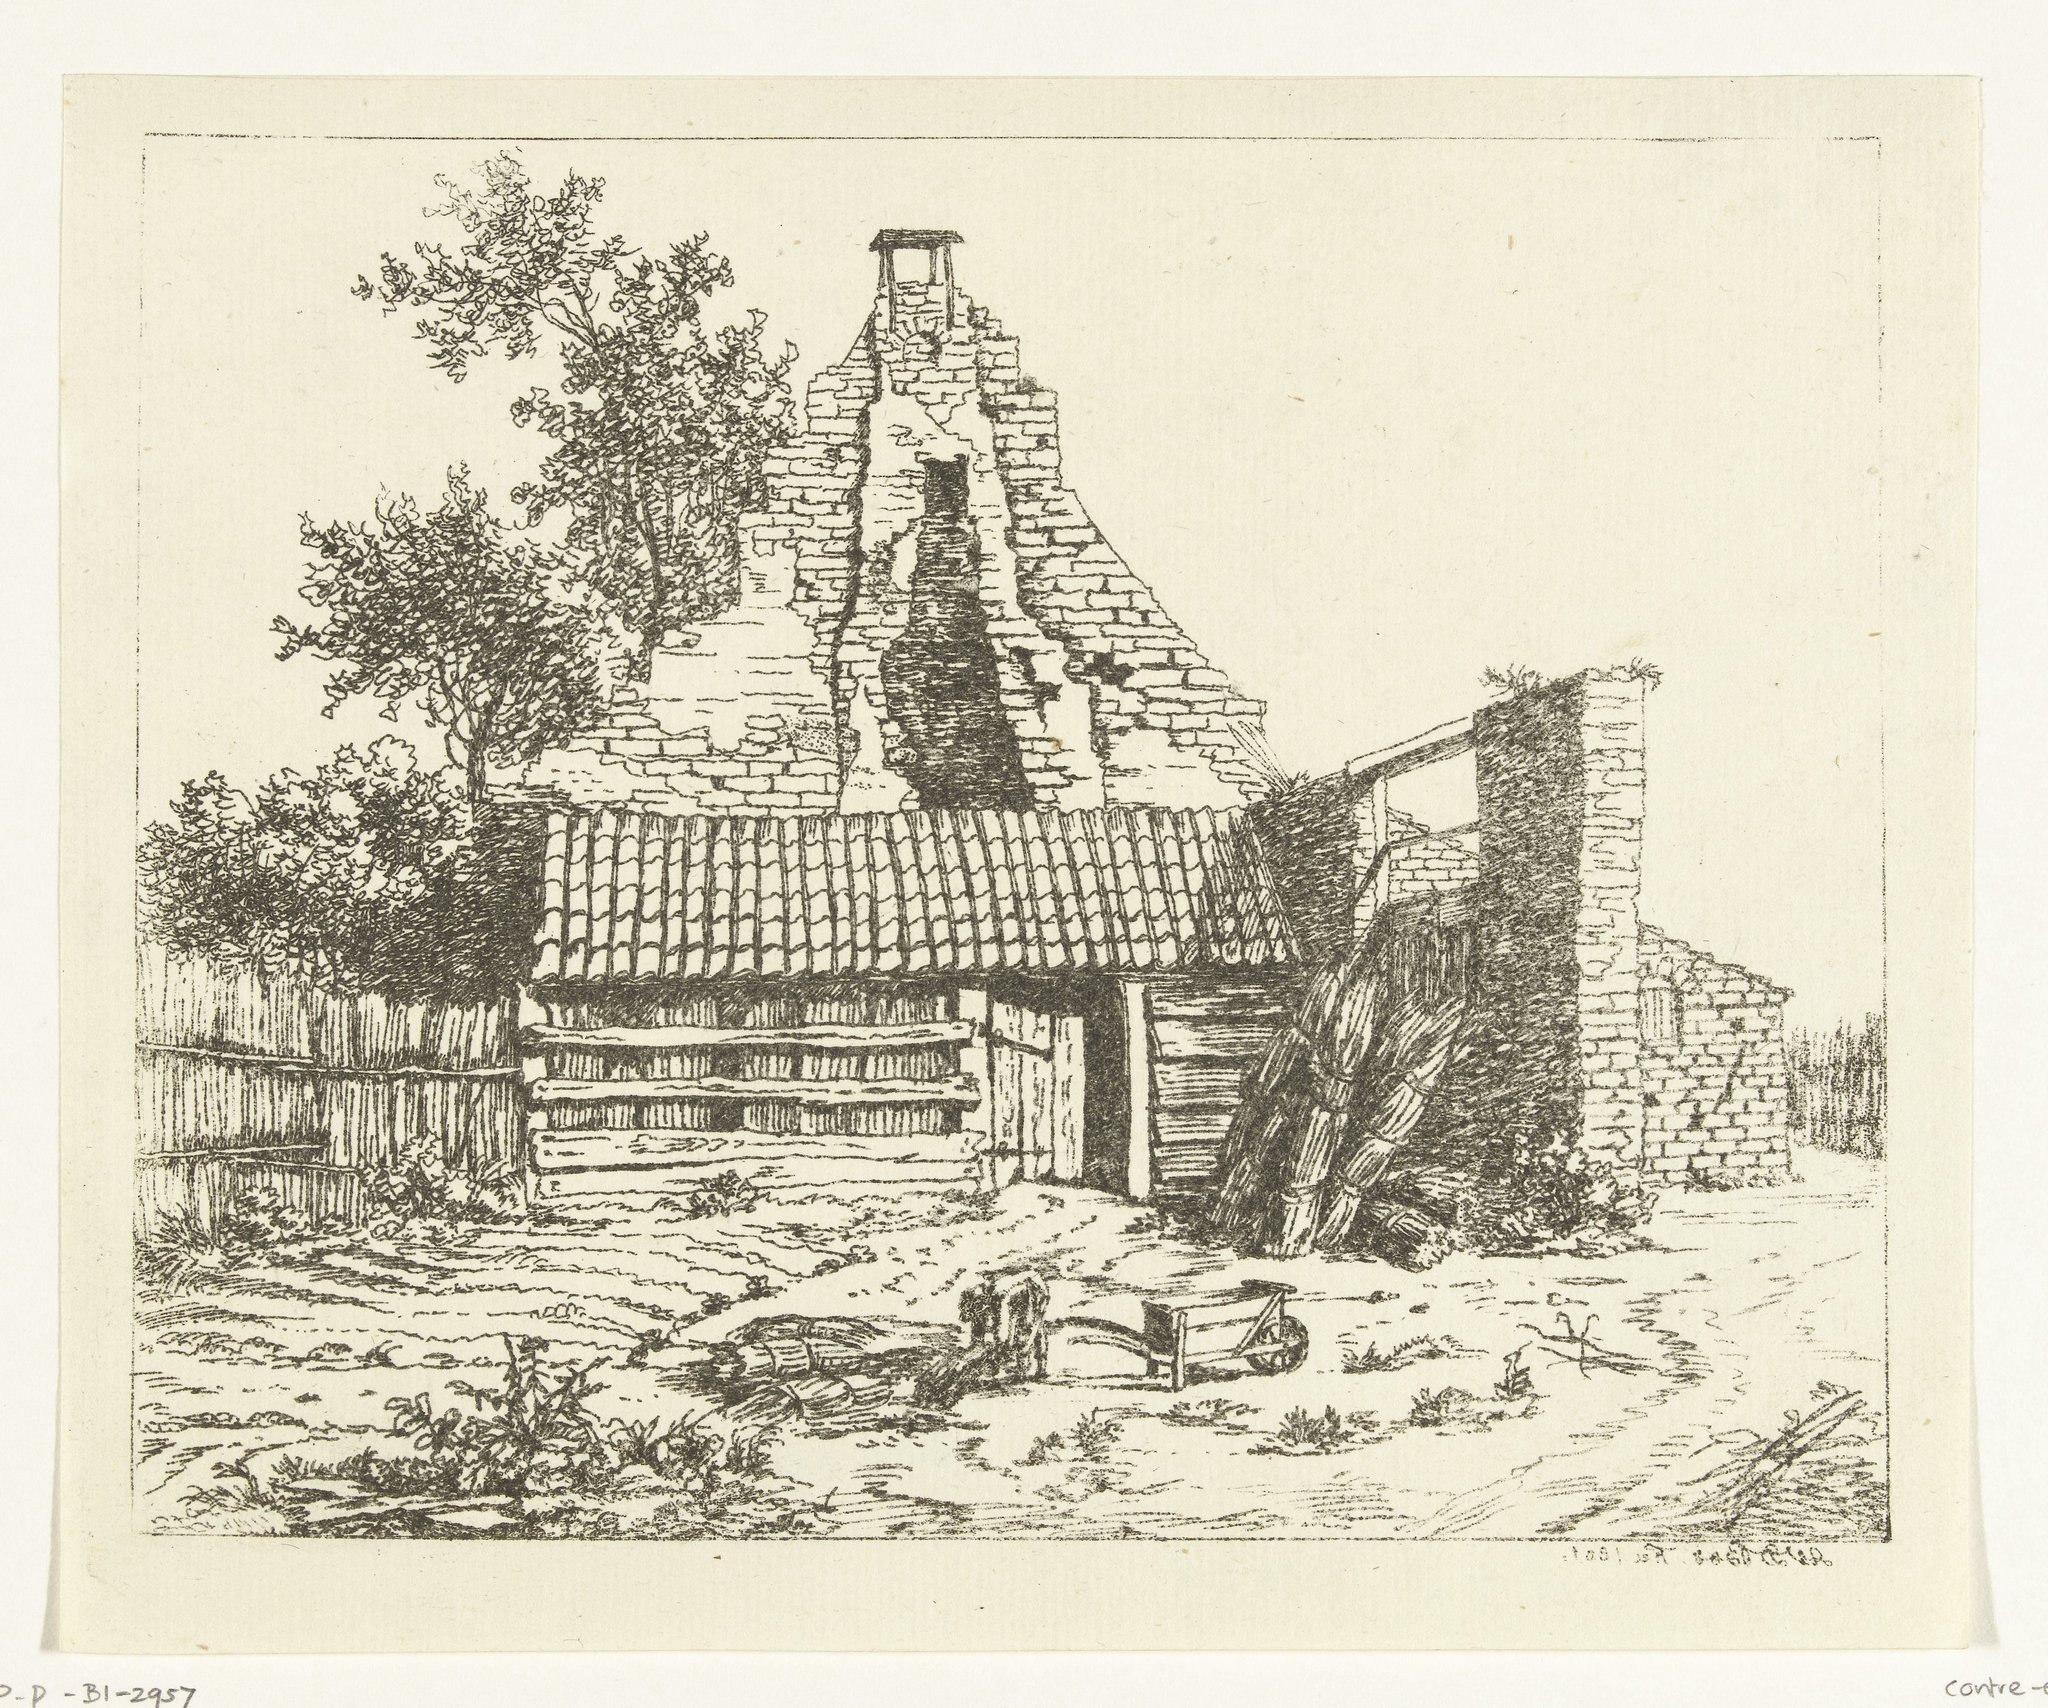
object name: print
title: Rietsijder voor de ruïne van het Huis Snaatburg te Maarssen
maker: anthonie van den bos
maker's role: draughtsman, print maker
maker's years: 1763-1838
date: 1801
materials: paper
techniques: printmaking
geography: netherlands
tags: ruin of a dwelling, house, castle, etc., reeds, rushes ~ building material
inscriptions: collector's mark: Lugt 2228